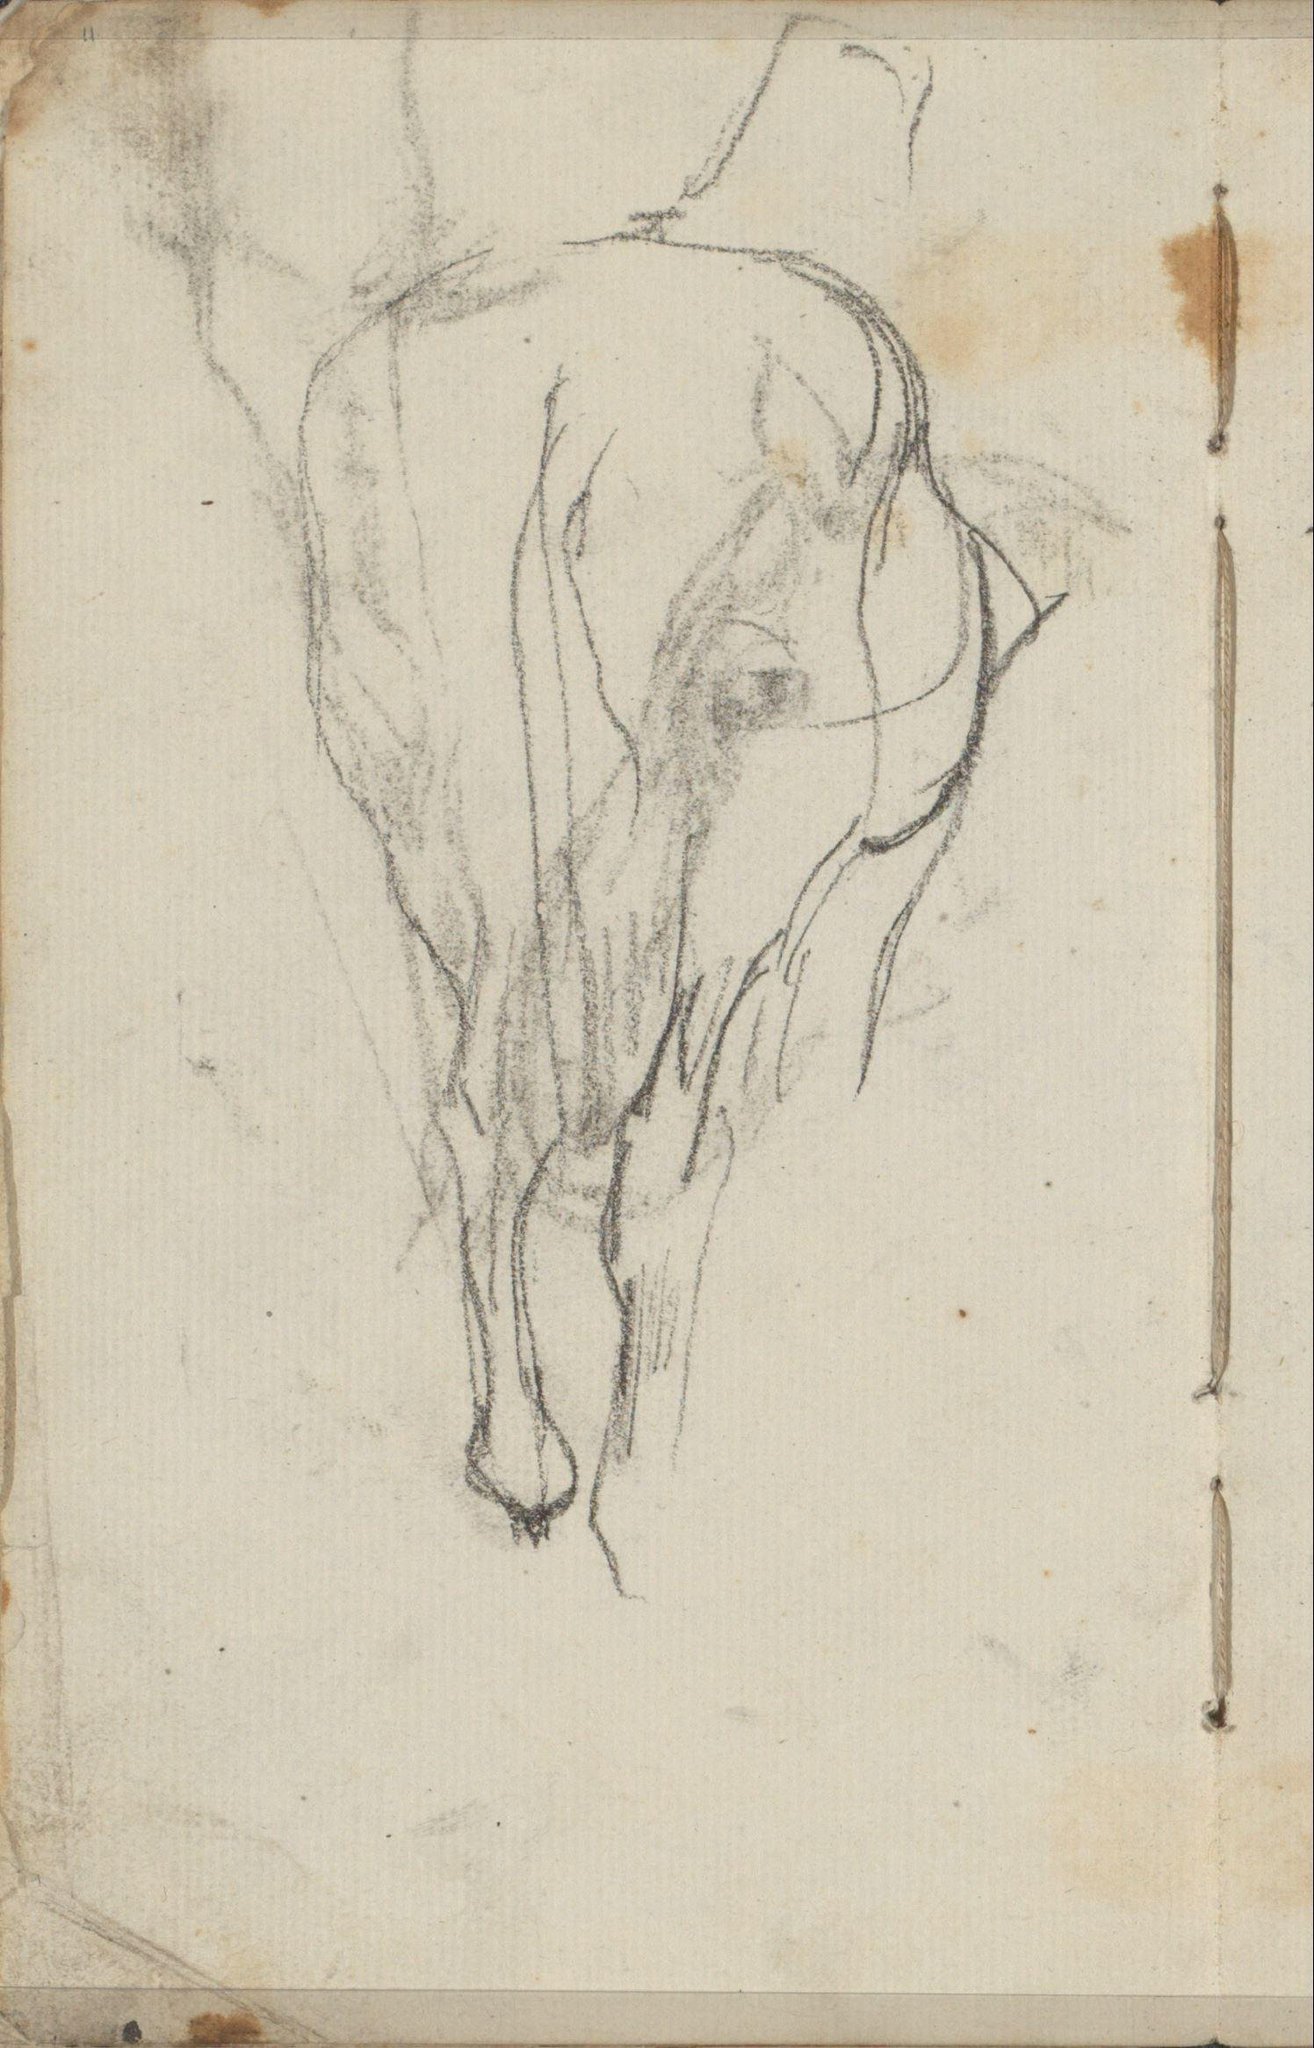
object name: sketchbook leaf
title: Paard, van achteren gezien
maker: george hendrik breitner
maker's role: draughtsman, painter, print maker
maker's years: 1857-1923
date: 1883-1885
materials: chalk, paper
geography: the hague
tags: horse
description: Pagina 11 uit een schetsboek met 17 bladen.